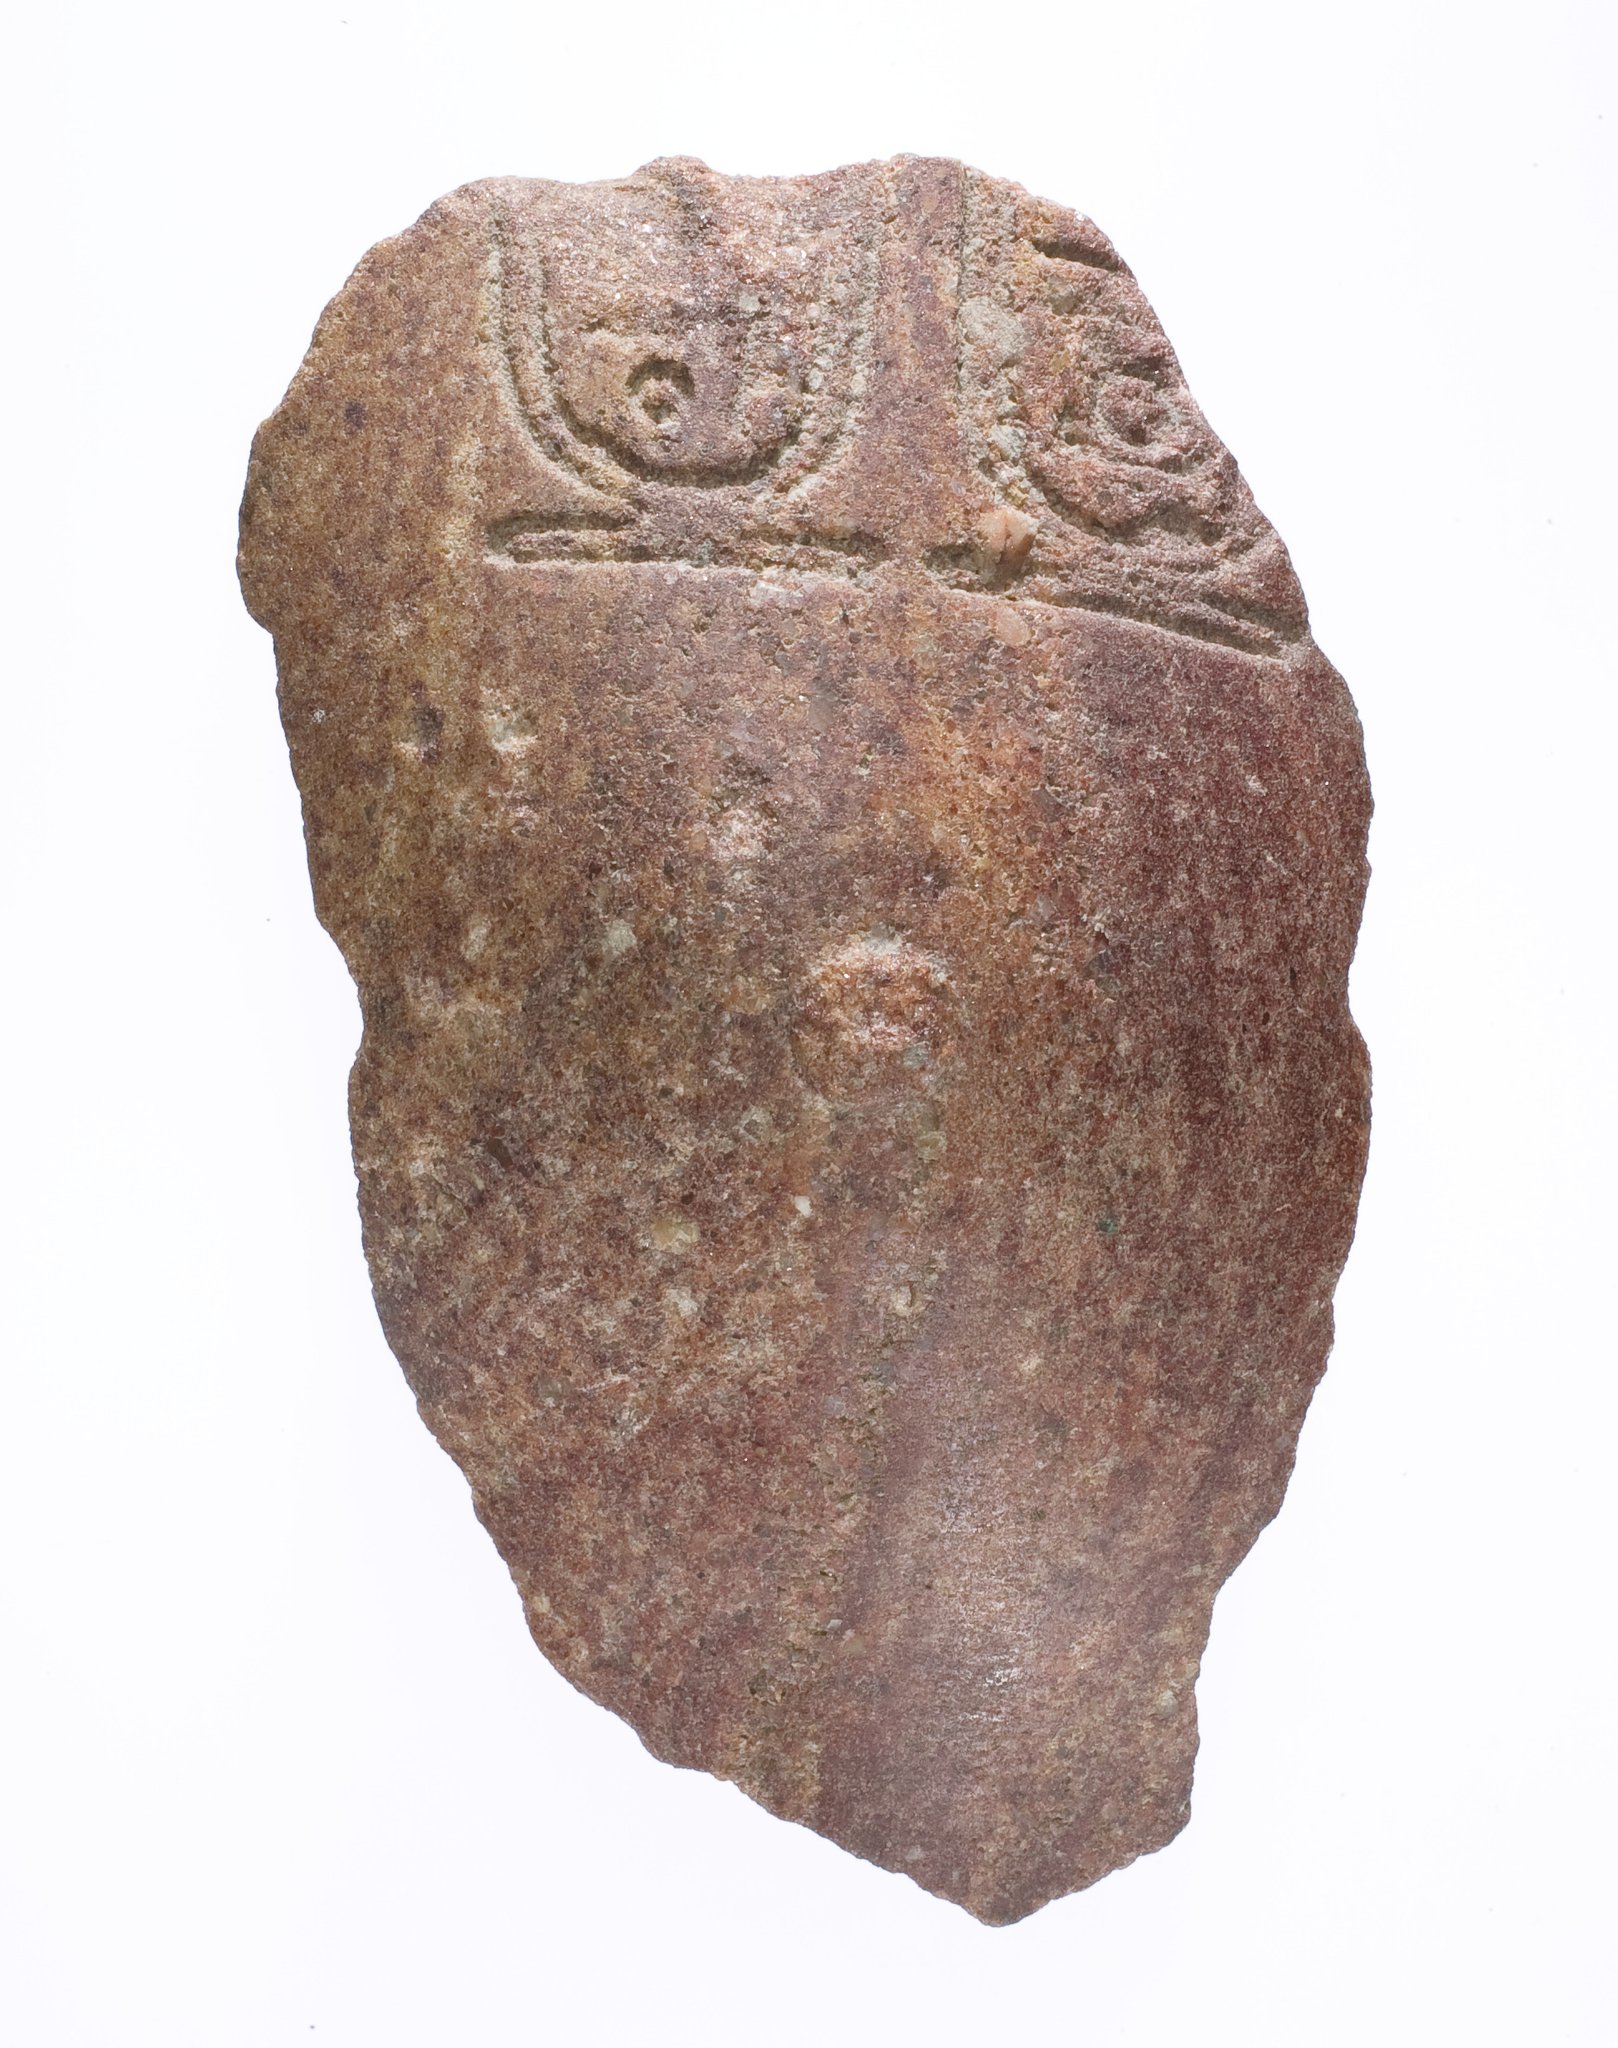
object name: chest, aten cartouch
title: Male breast with lower part of Aten cartouches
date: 1353-1336 BCE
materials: quartzite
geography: egypt